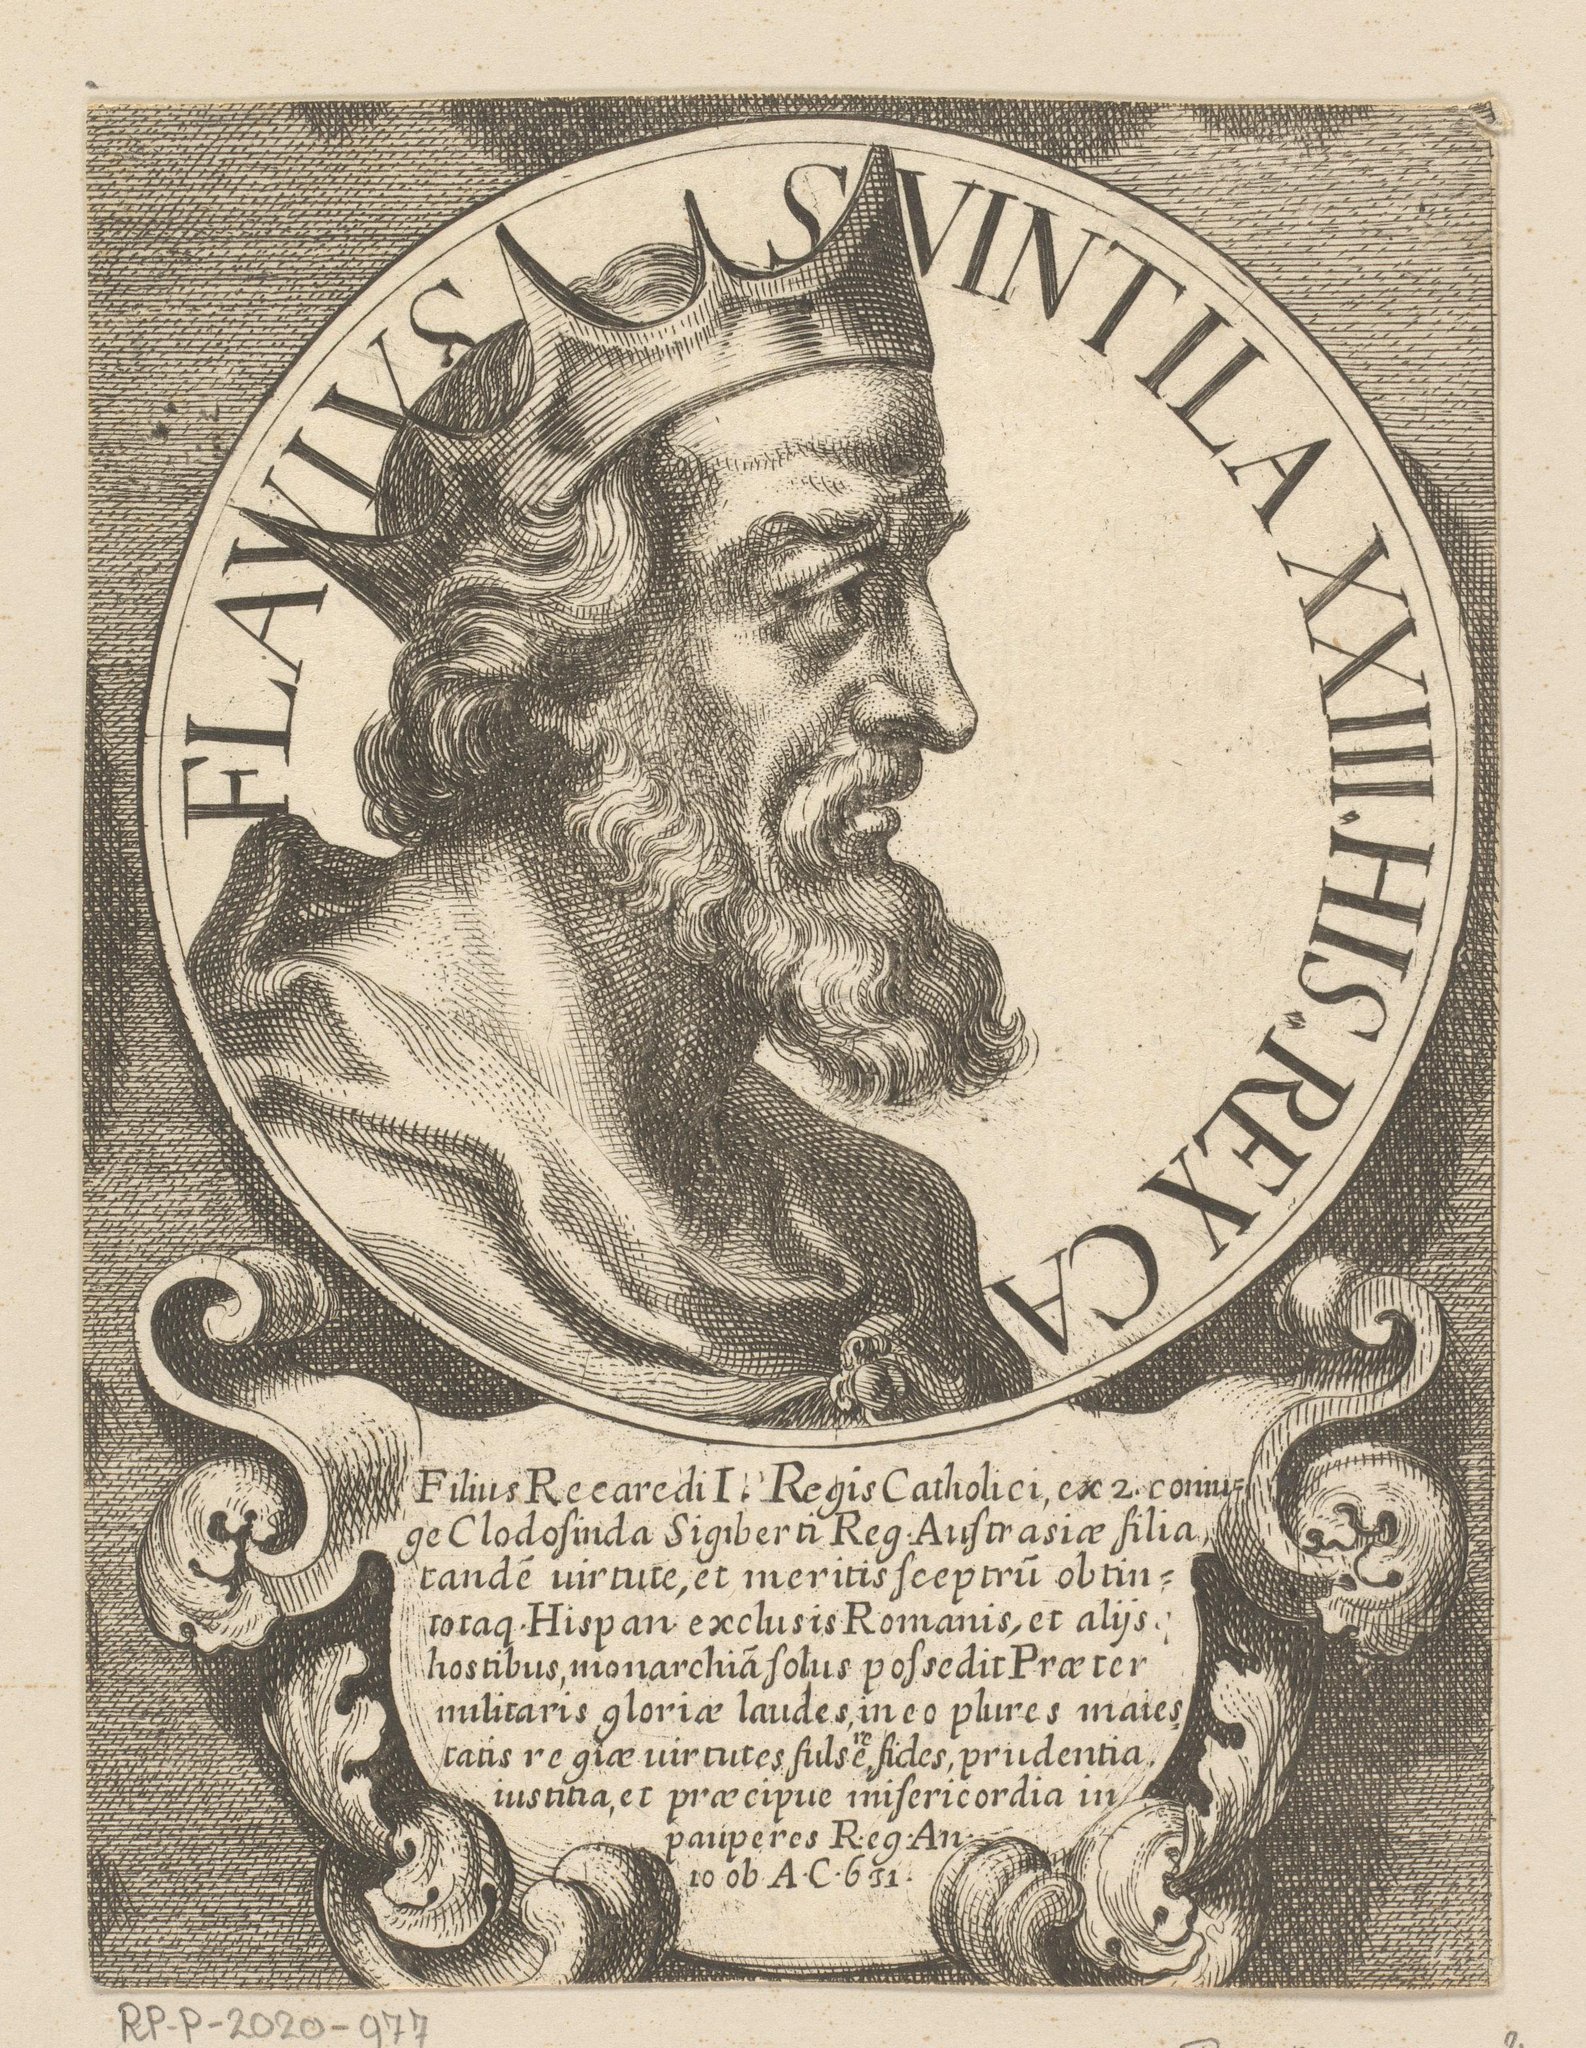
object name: print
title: Flavius Suintila XXIII His Rex Ca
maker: arnold van westerhout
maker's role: print maker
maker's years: 1651-1725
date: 1684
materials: paper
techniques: engraving, etching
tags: historical persons, ruler, sovereign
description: Portret ook gebruikt in: Niphus, Agustinus. Effigies et series regum Hispaniae primum ex Gothis Christianorum (...). Rome: s.n., 1684.